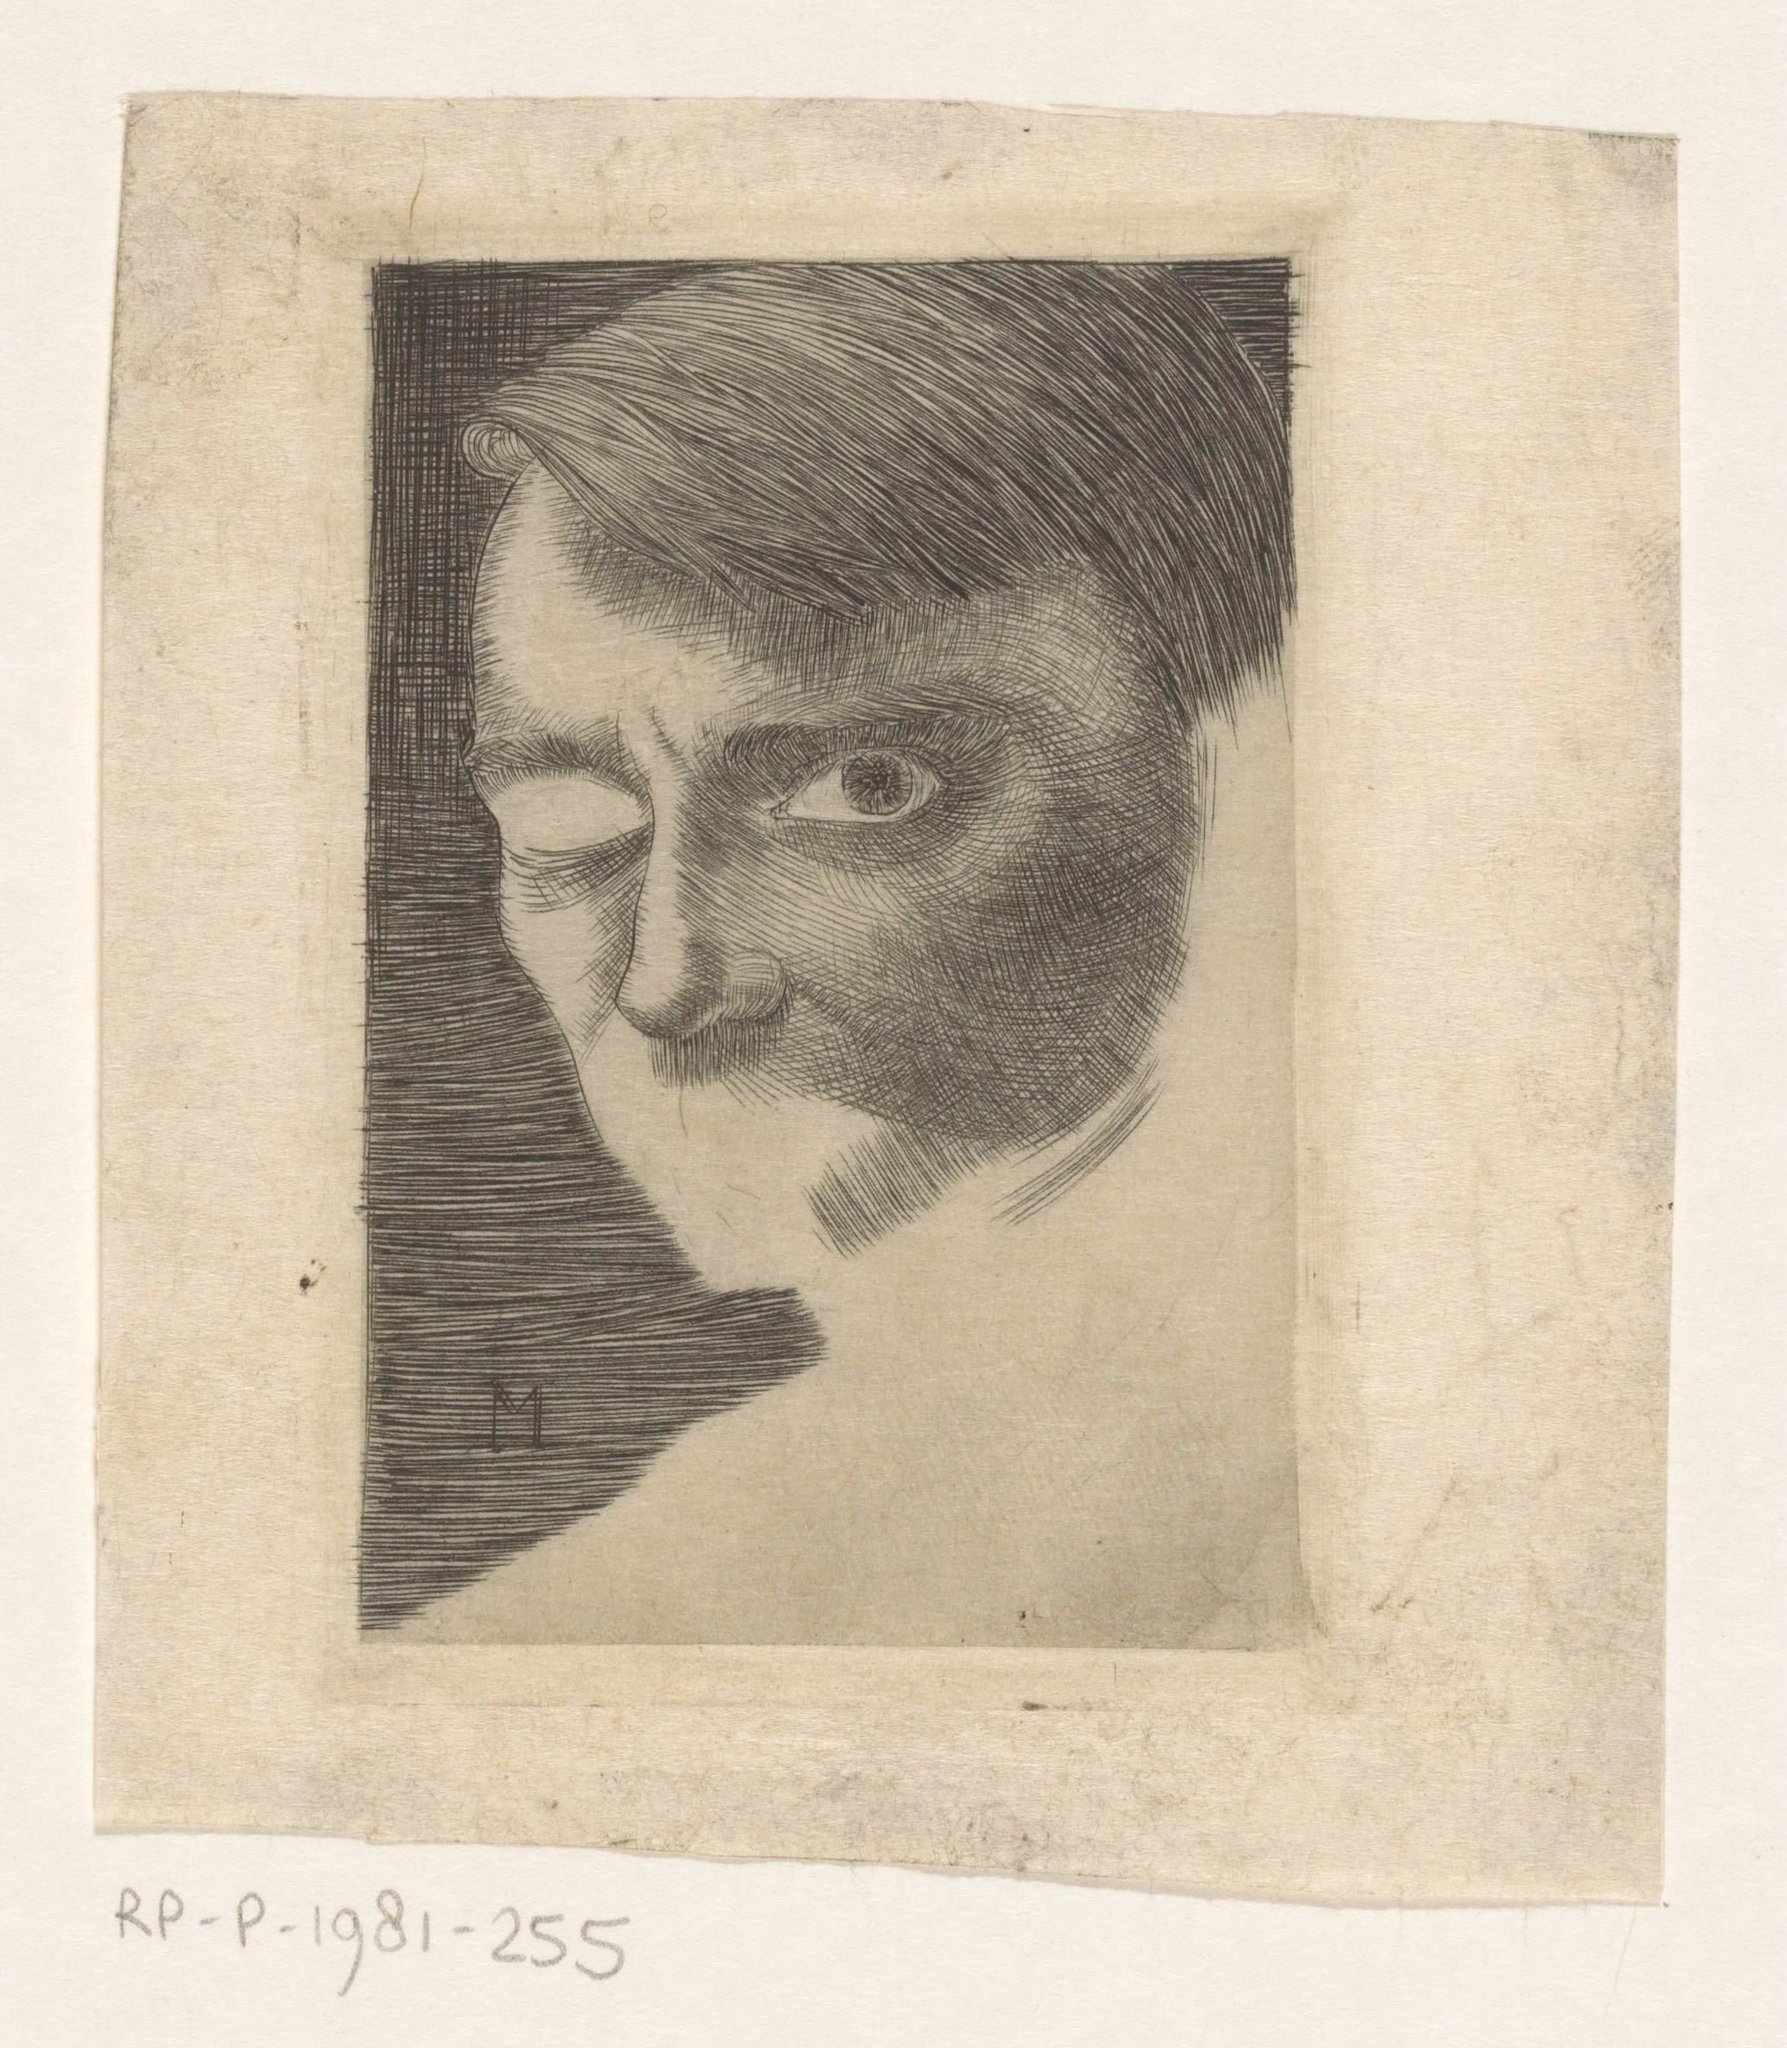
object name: print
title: Zelfportret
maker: jan mankes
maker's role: draughtsman, painter, print maker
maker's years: 1889-1920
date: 1917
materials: paper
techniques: engraving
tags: painter, jan mankes, portrait, self-portrait of artist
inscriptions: collector's mark: Lugt 2228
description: Rechteroog, mond, kin, linkeroor en hals ontbreken.